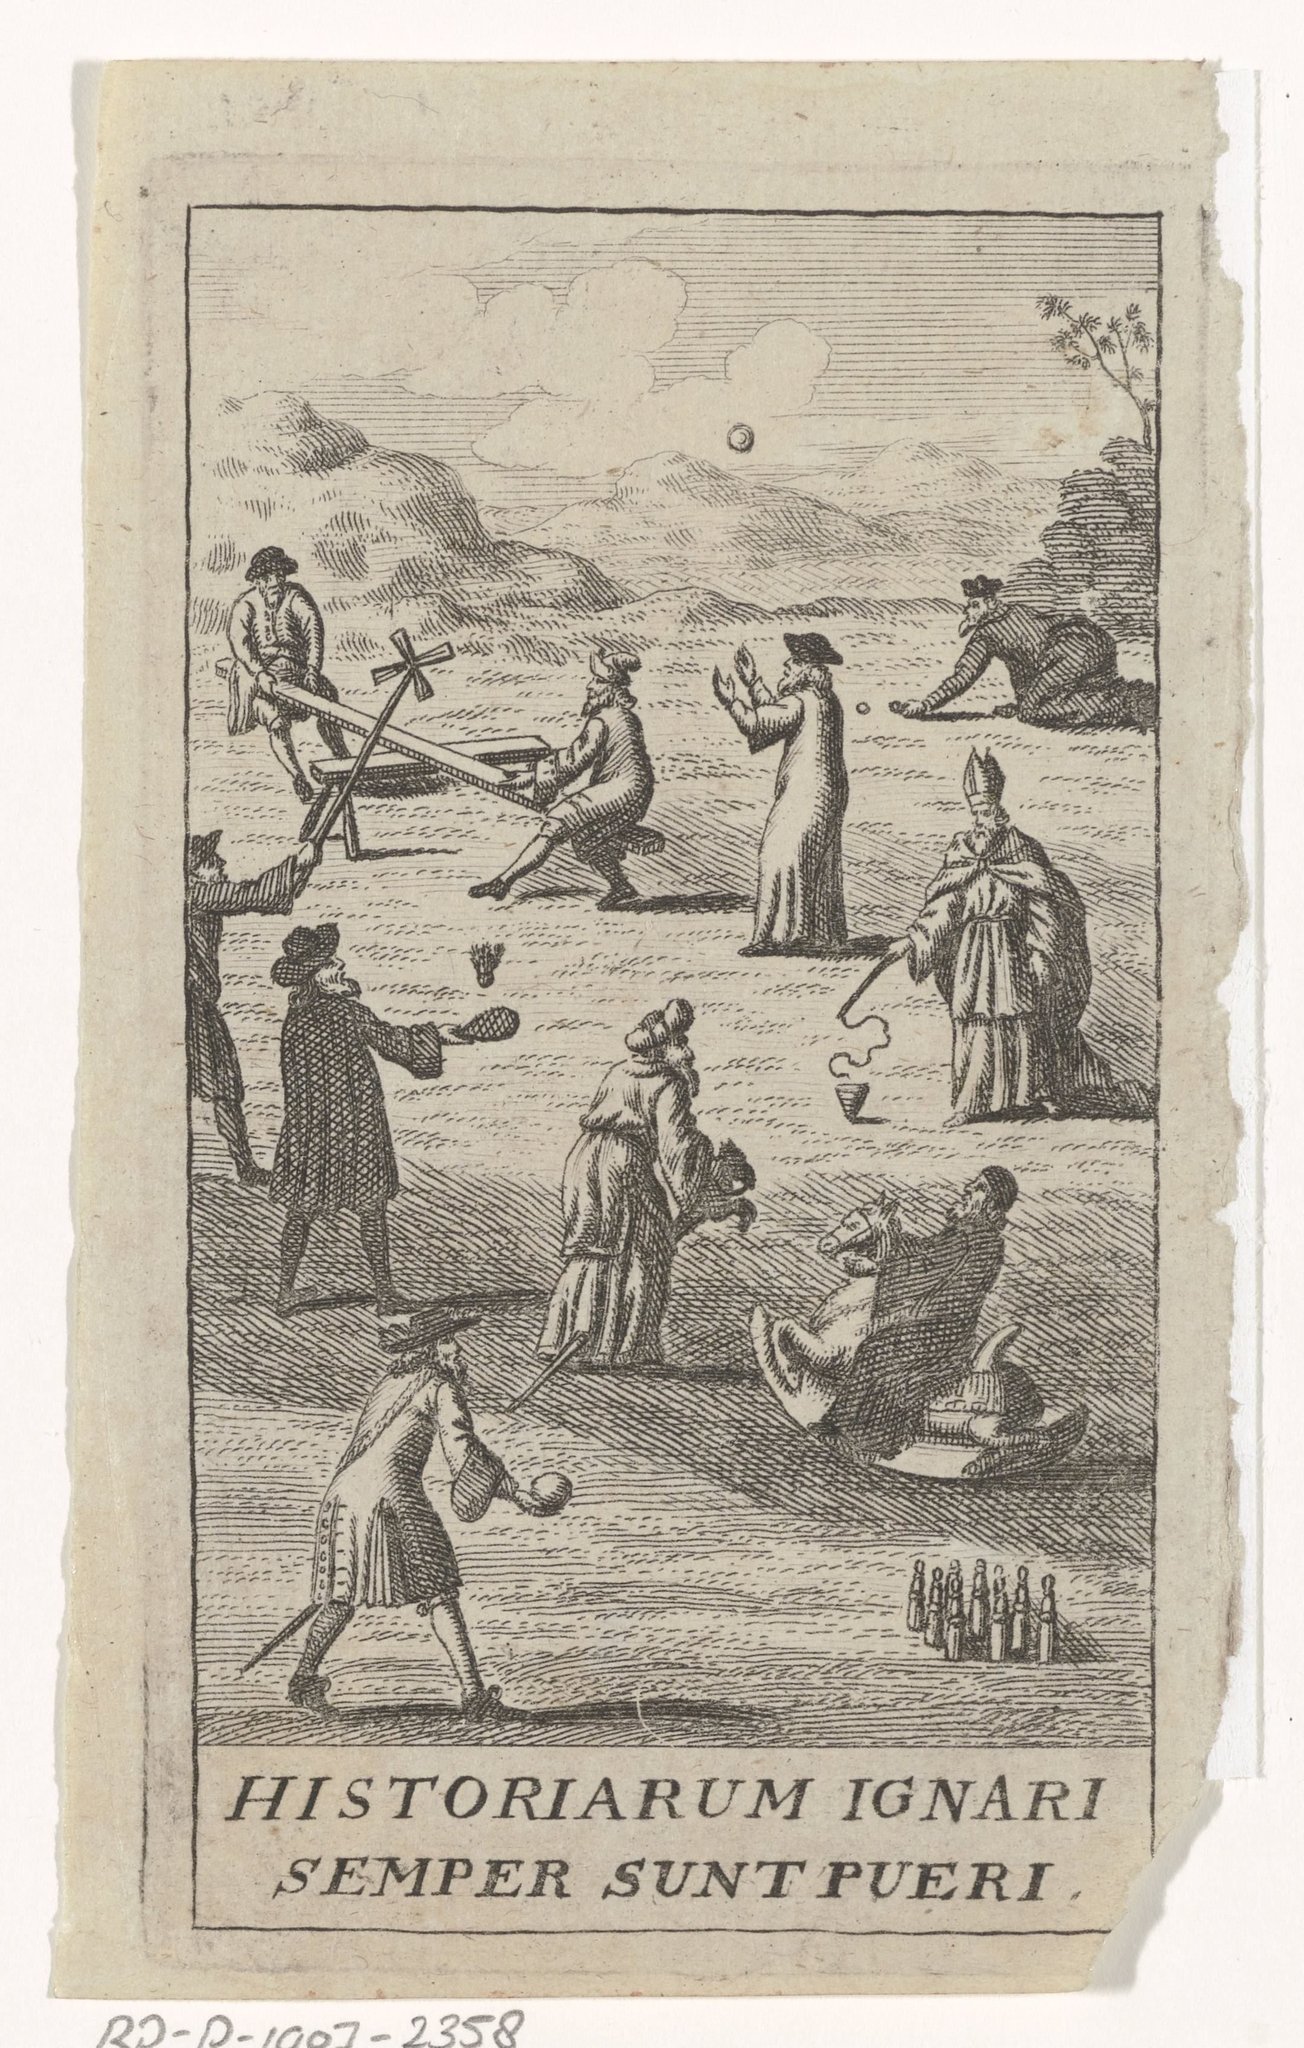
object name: print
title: Historiarum ignari semper sunt pueri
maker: Anonymous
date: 1650-1850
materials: paper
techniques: engraving, etching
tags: children's games and plays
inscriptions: collector's mark: Lugt 2228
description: Oude mannen spelen kinderspelletjes, zoals kegelen, rijden op een hobbelpaard, tollen, knikkeren, spelen op de wip. De spreuk in het Latijn betekent: Wie de geschiedenis negeert, blijft eeuwig kind. Mogelijk een titelprent.